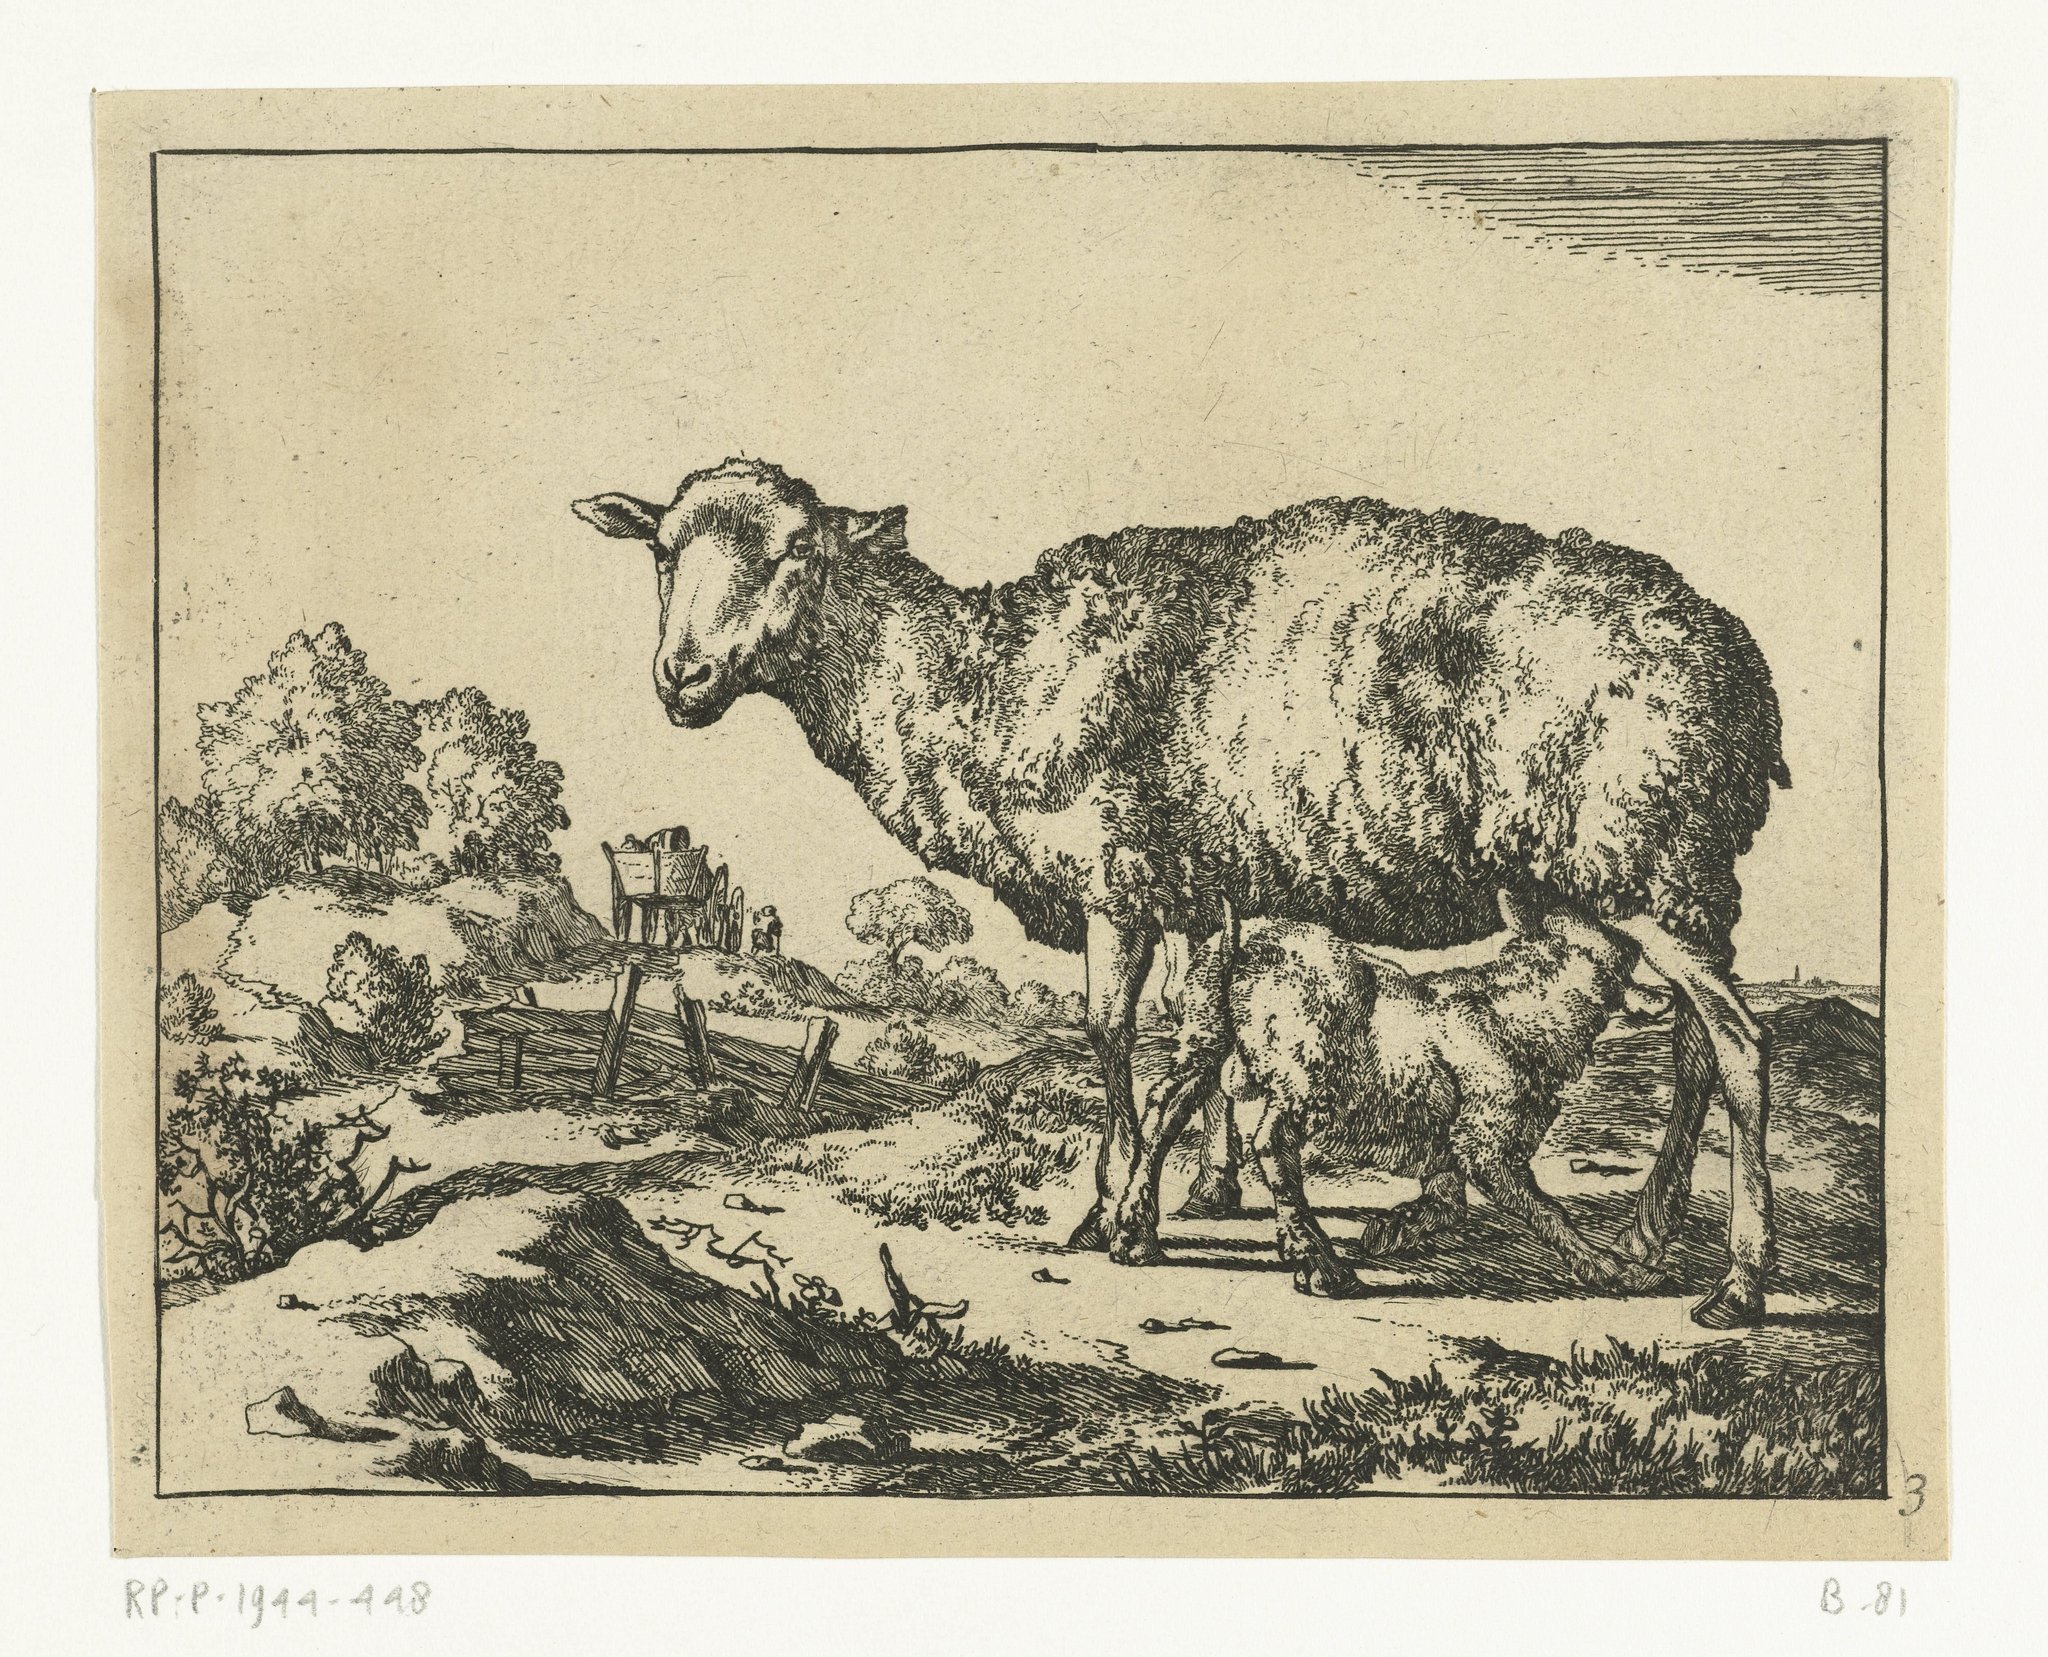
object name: print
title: Schaap met drinkend lam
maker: marcus de bye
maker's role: print maker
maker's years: 1639-1688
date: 1664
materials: paper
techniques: etching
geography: the hague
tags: sheep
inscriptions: collector's mark: Lugt 2228